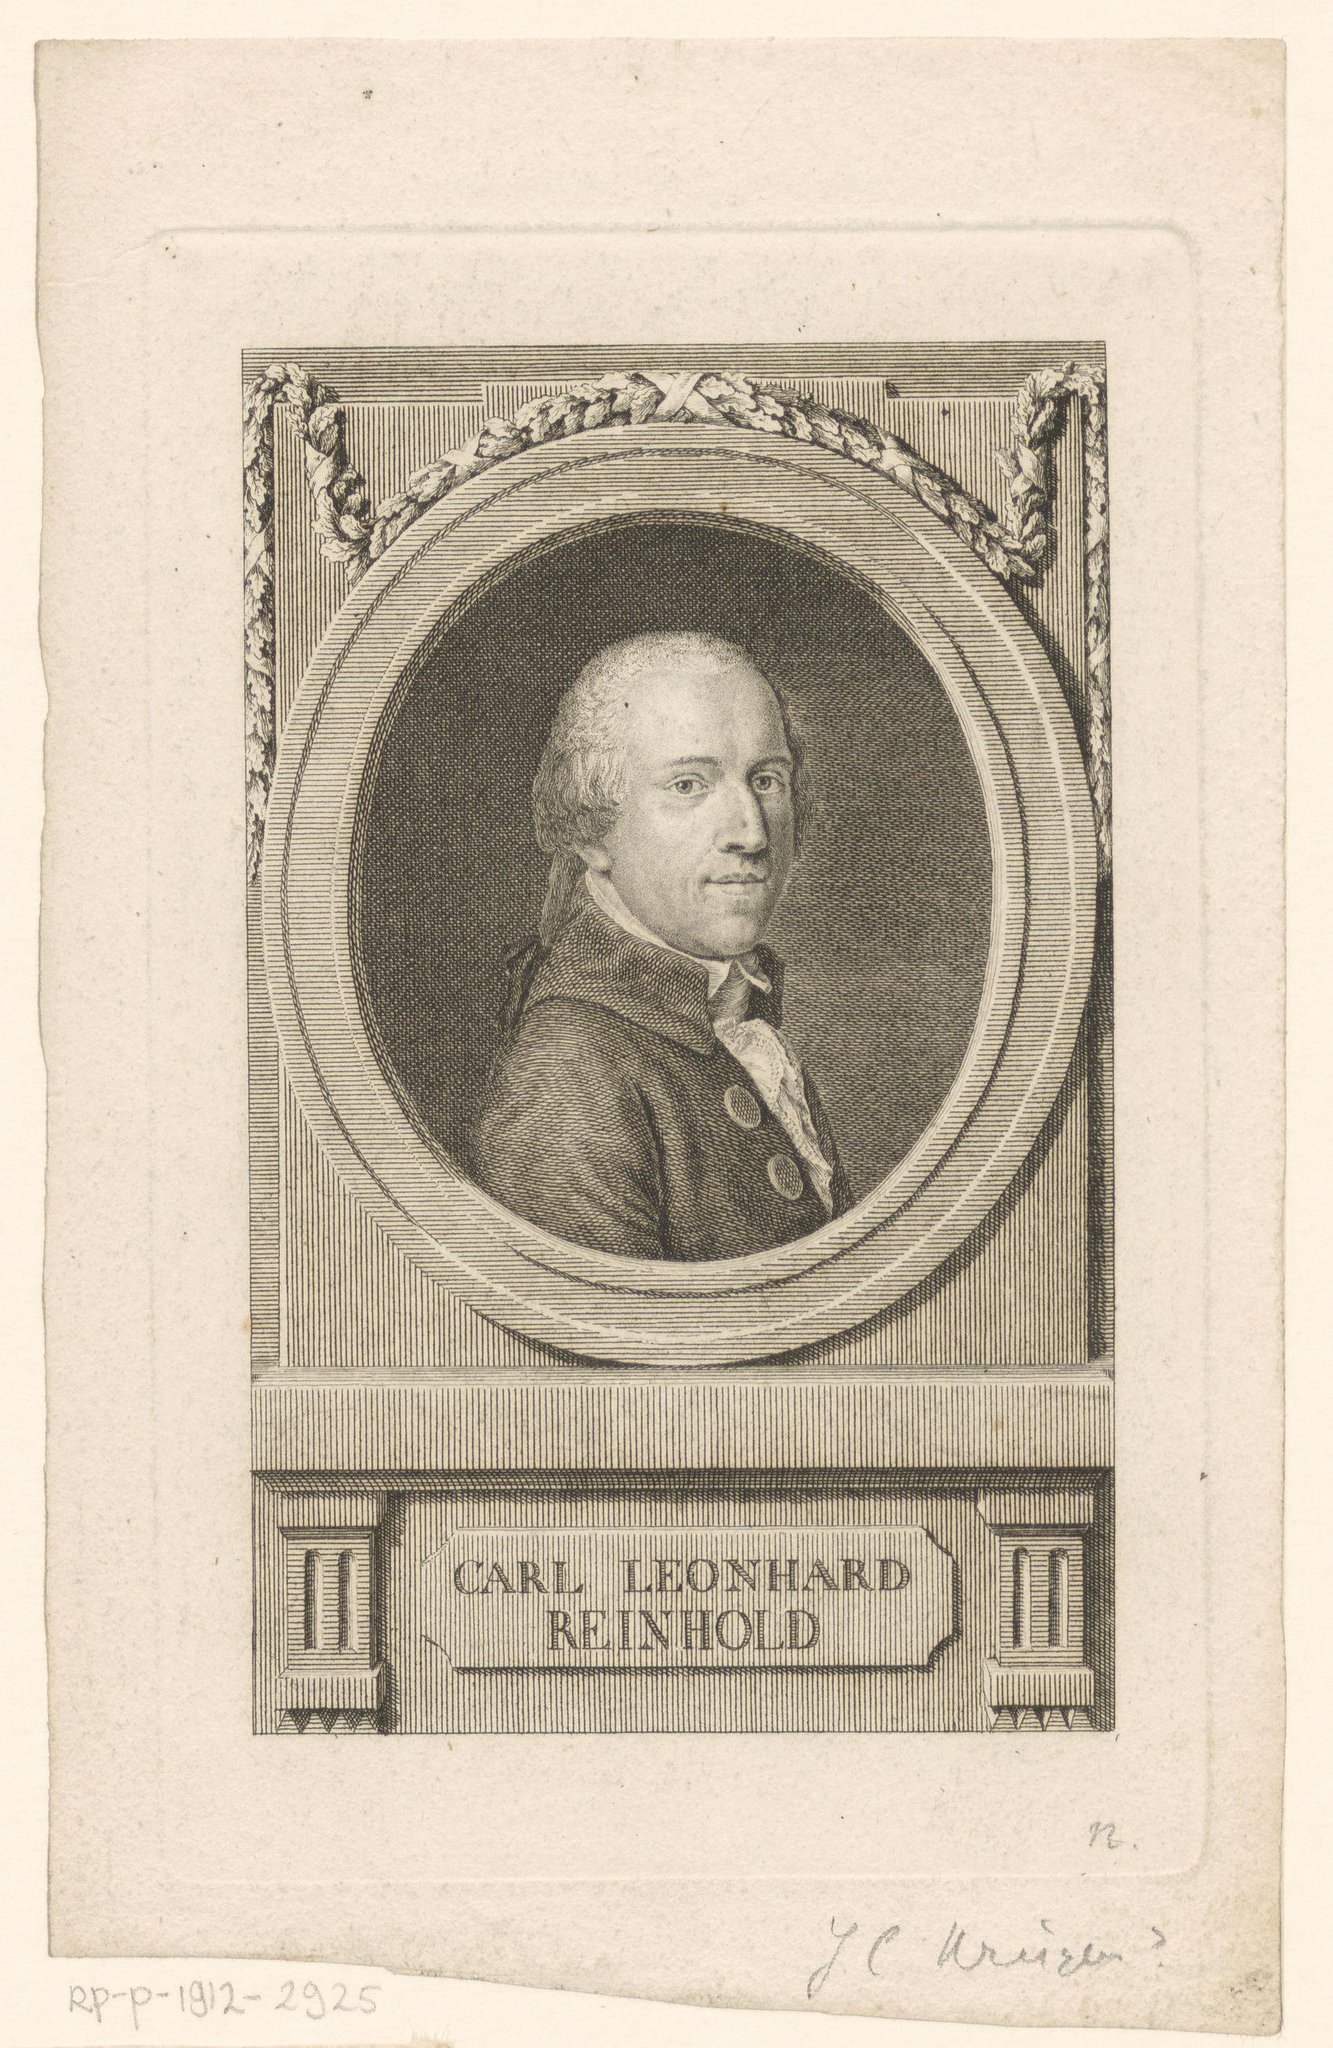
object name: print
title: Portret van Carl Leonhard Reinhold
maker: johann conrad krüger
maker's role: artist, painter, print maker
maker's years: 1733-1791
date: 1743-1791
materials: paper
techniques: engraving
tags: vienna, historical persons, scholar, philosopher (+ portrait of scholar, scientist)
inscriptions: collector's mark: Lugt 2228